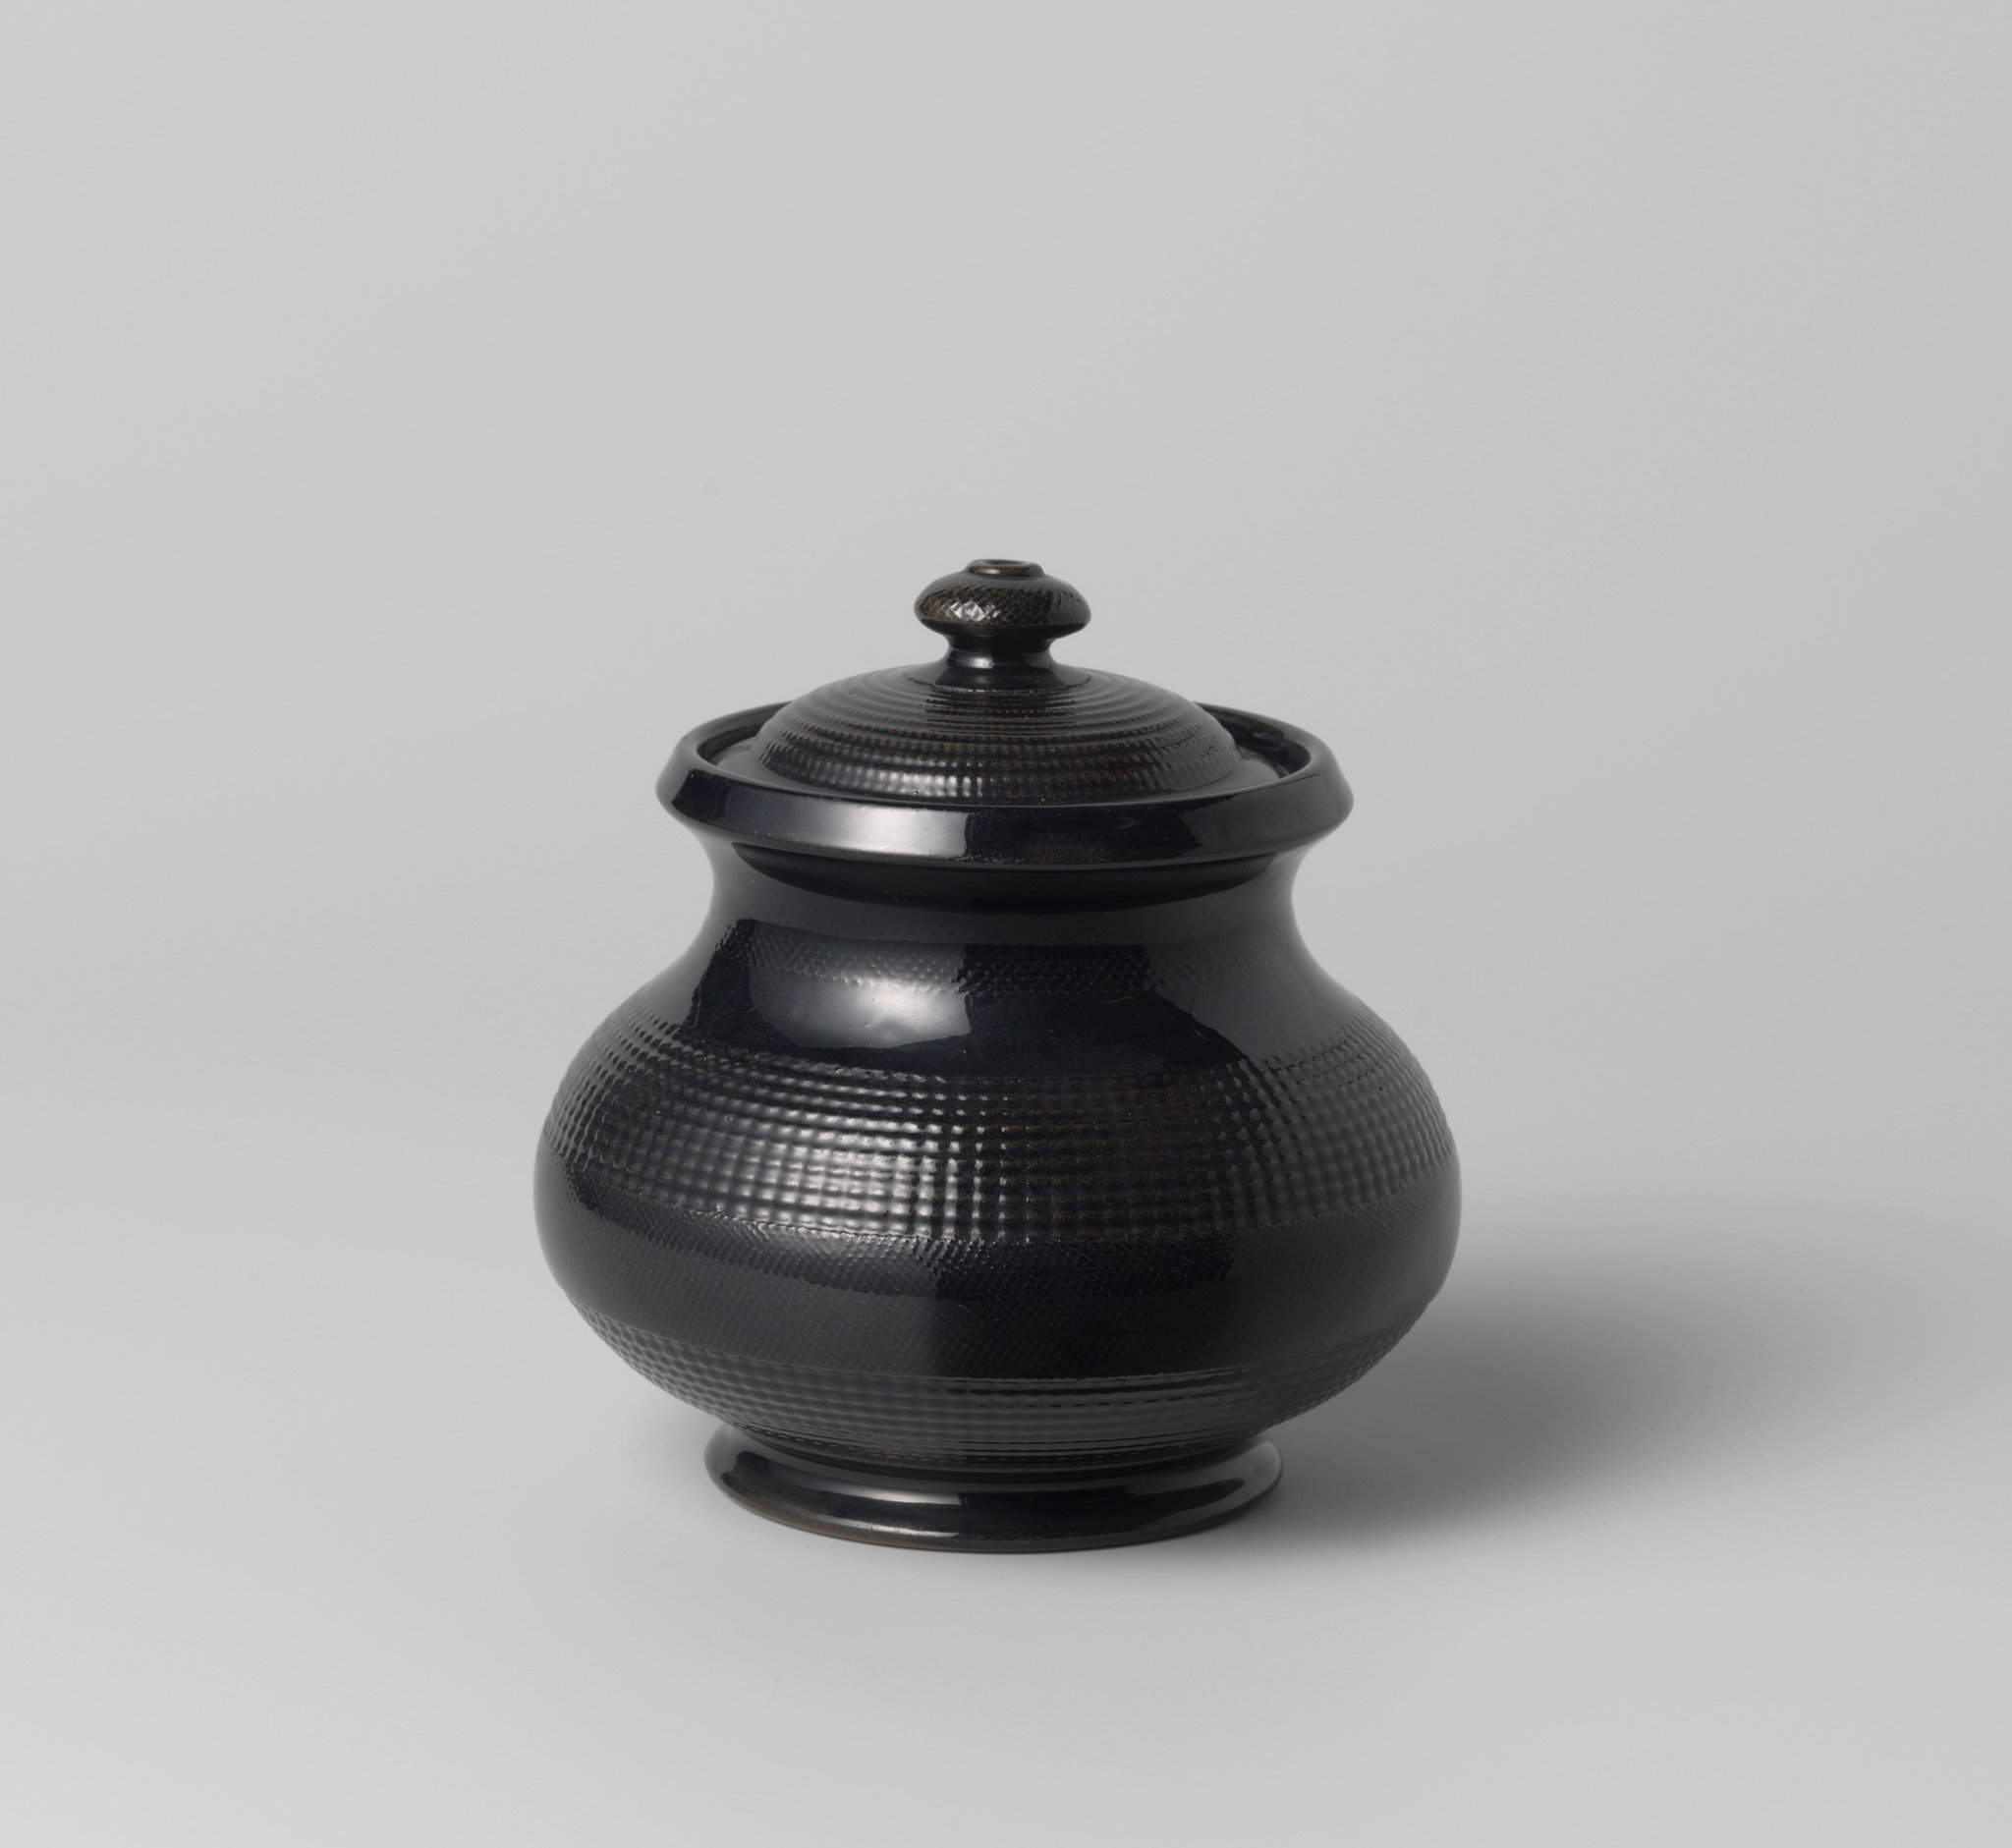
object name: sugar box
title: Deksel, zwart, gedecoreerd met ribbelranden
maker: petrus regout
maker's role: plateelbakker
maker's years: 1801-1879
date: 1860-1880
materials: stoneware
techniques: engels steengoed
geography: maastricht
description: Deksel van zwartsteen. Het deksel heeft afgeplatte knop met luchtgat.